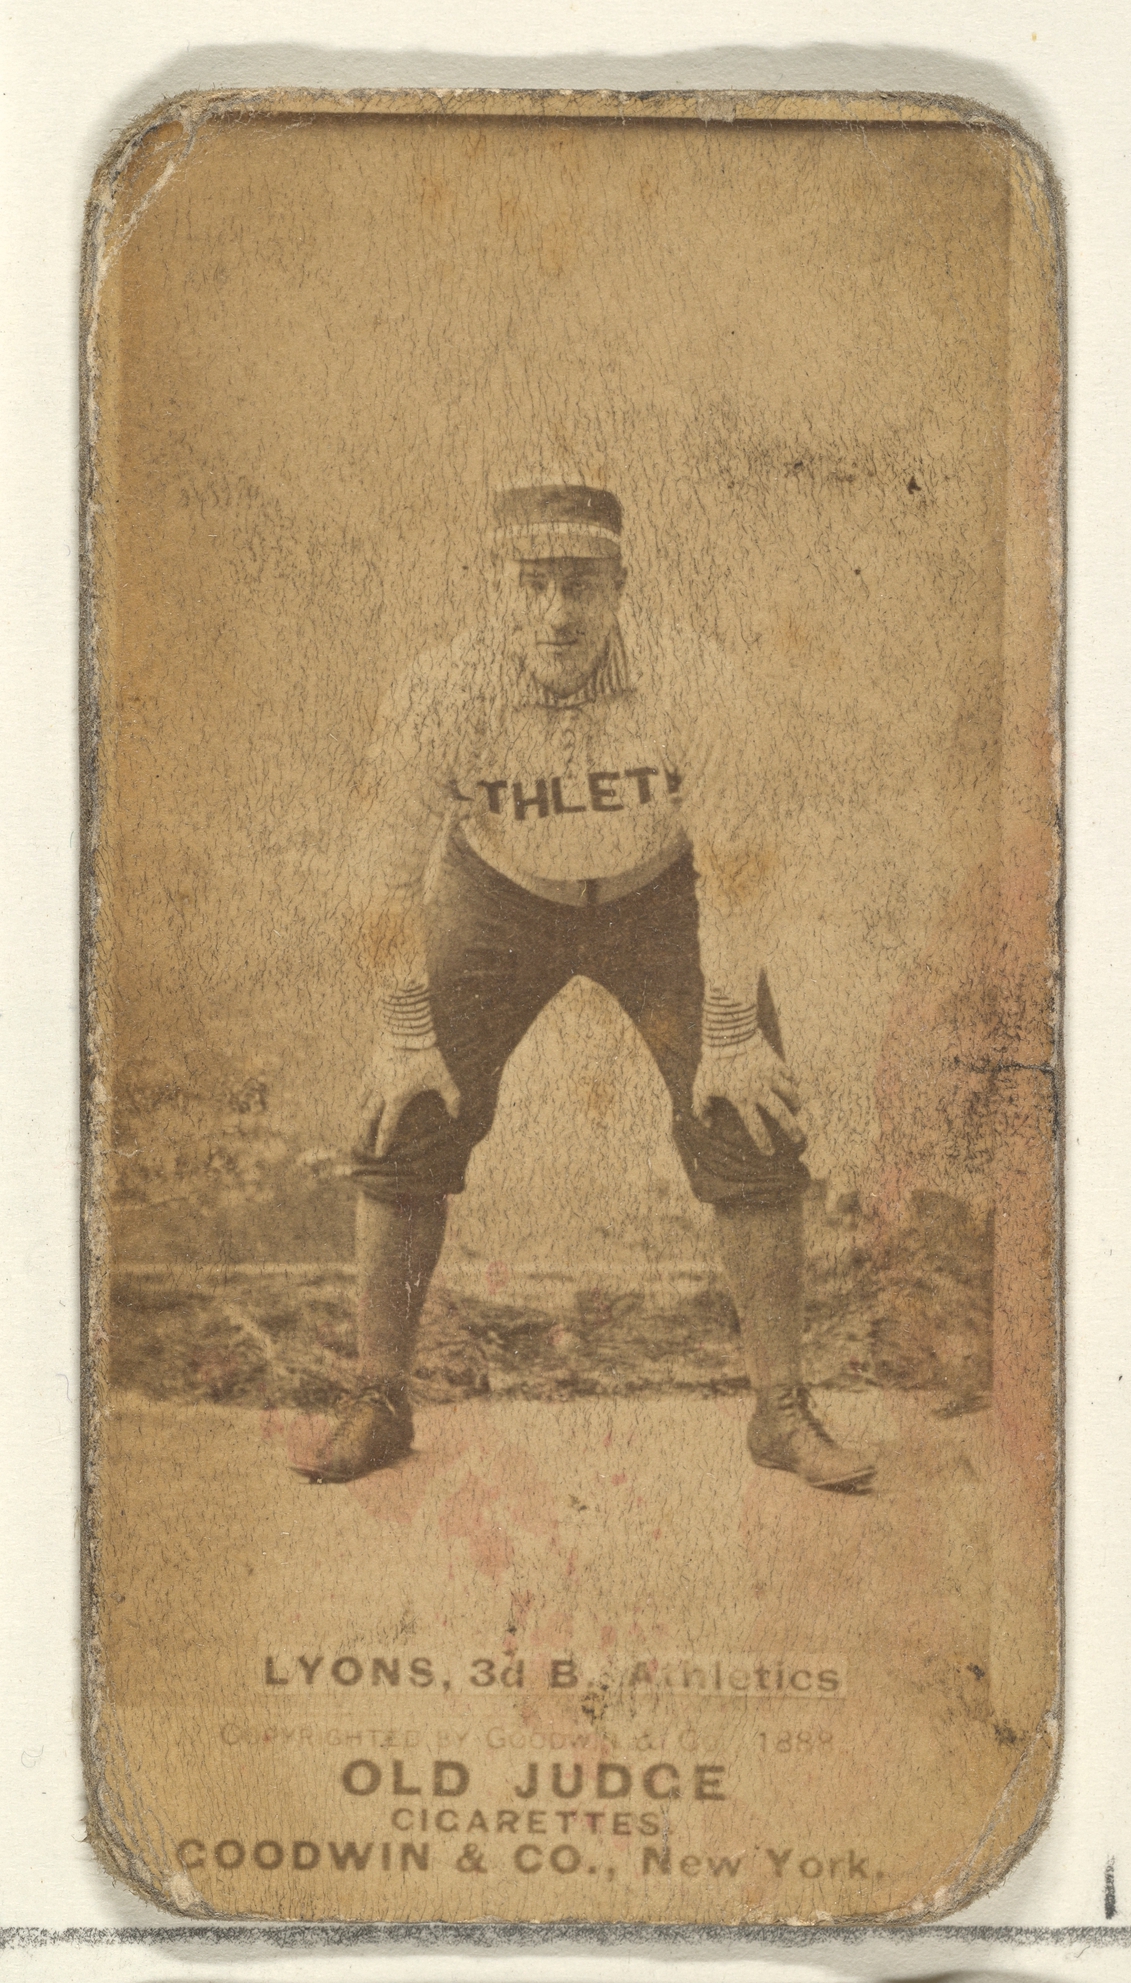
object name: baseball card, photograph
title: Lyons, 3rd Base, Philadelphia Athletics, from the Old Judge series (N172) for Old Judge Cigarettes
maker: goodwin & company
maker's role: publisher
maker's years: 1850-1950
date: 1888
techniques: albumen silver print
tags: men,portraits,baseball,athletes